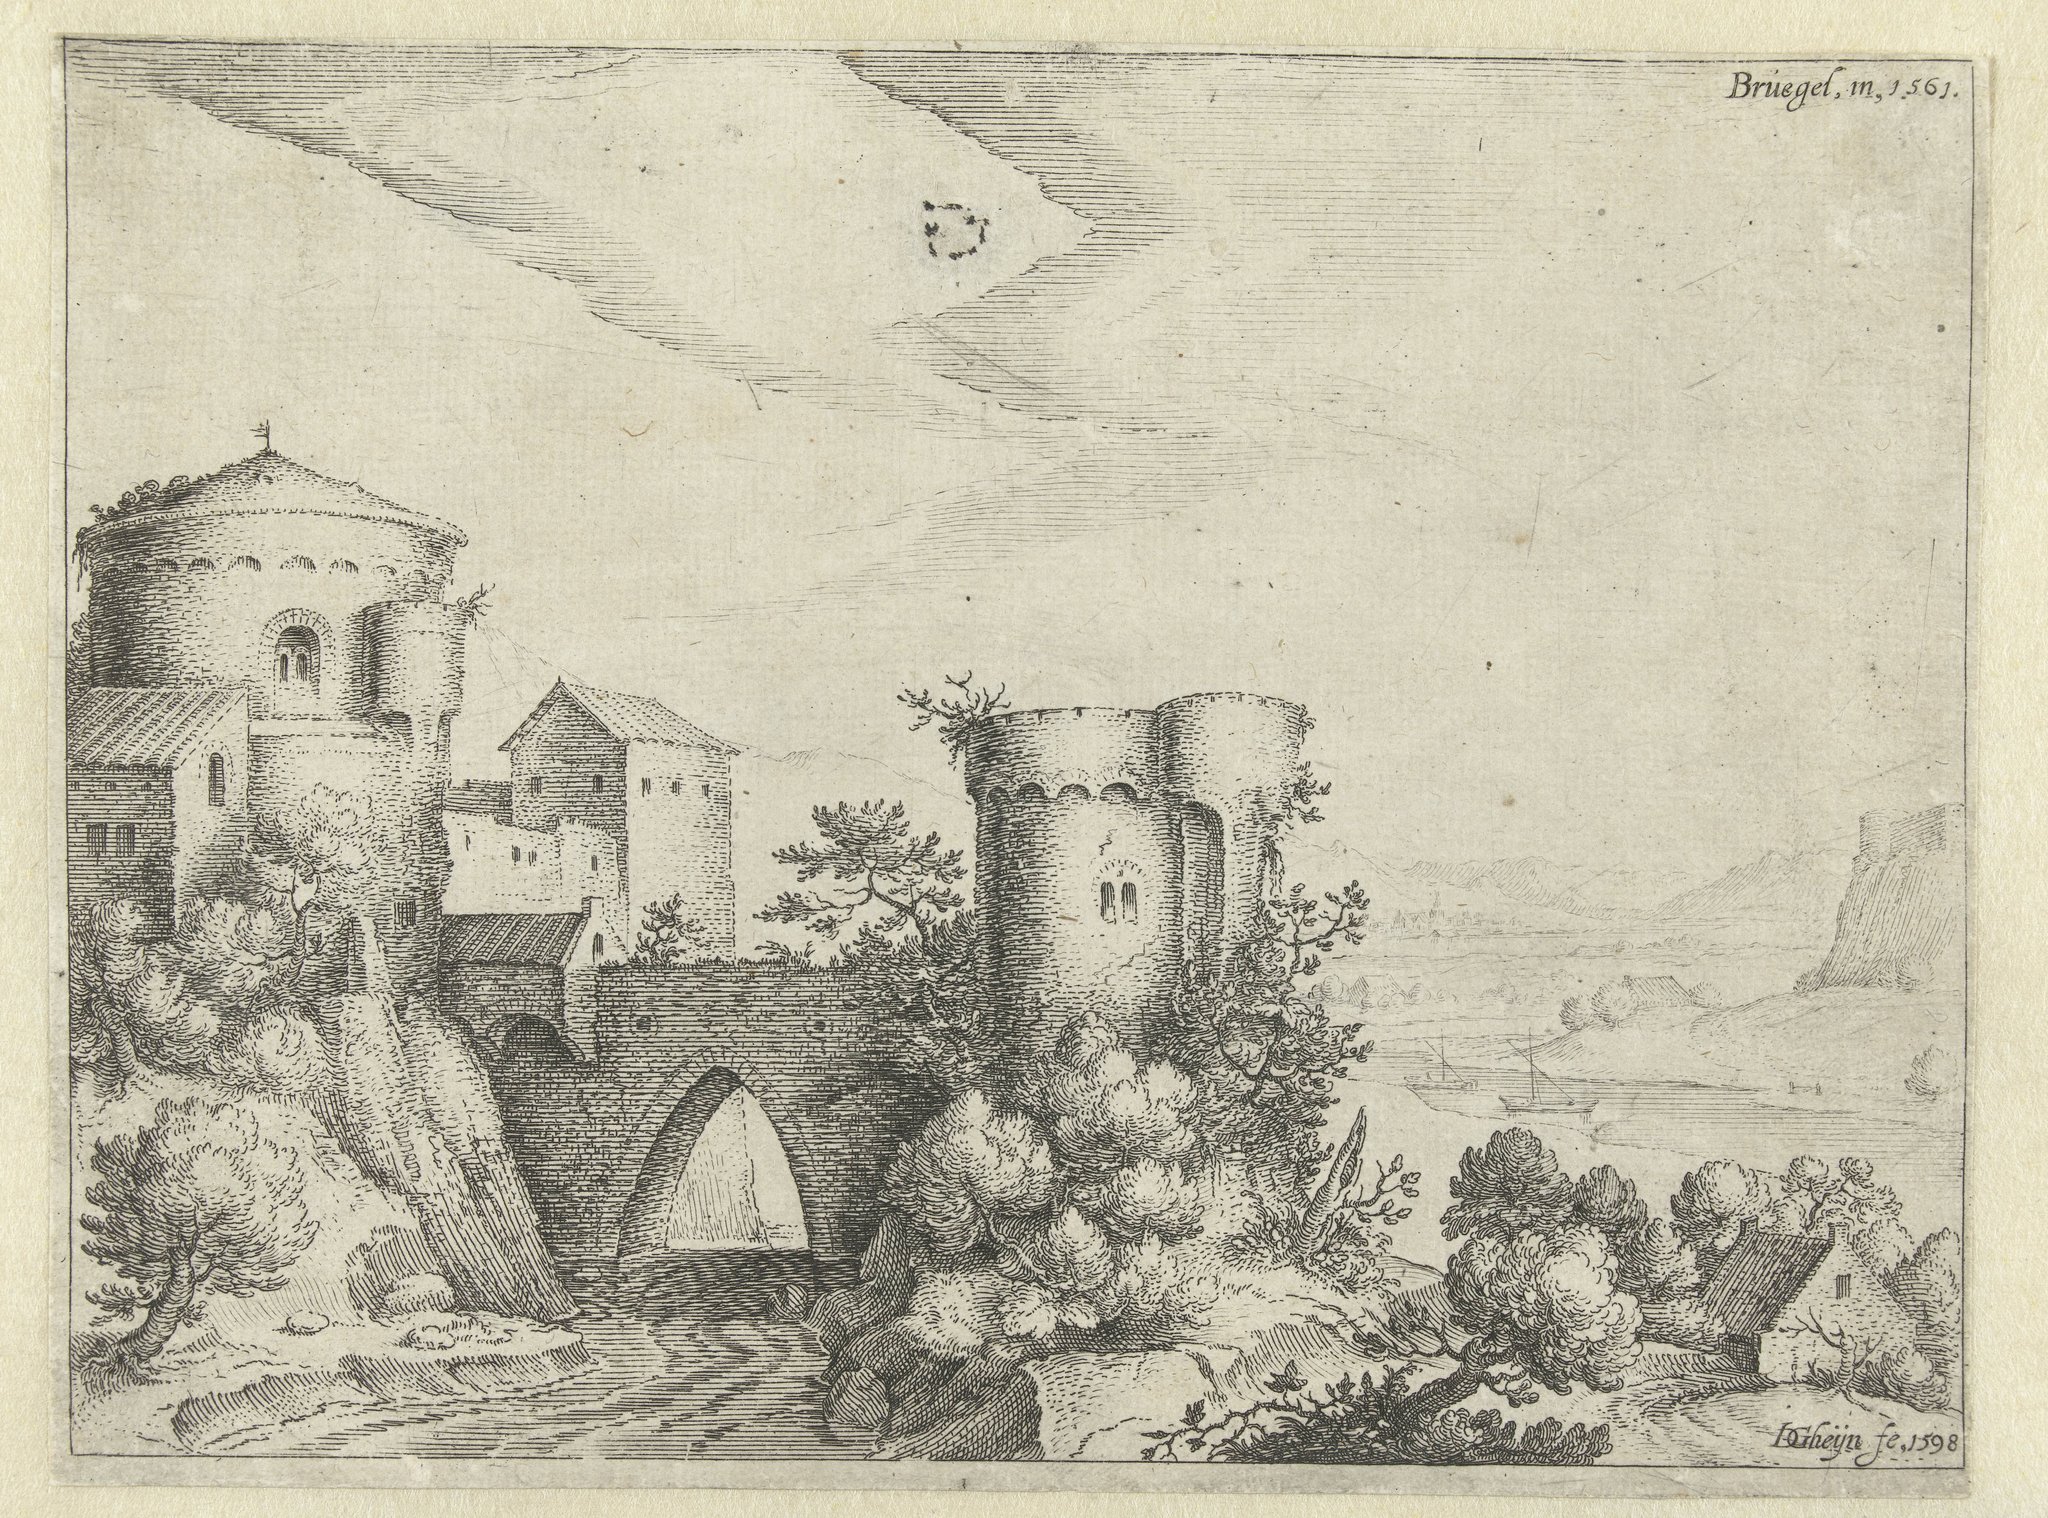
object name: print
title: Rivierlandschap met kasteel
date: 1598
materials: paper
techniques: etching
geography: netherlands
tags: castle, river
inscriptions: collector's mark: Lugt 845, collector's mark: Lugt 2228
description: Kasteel aan rivier in bergachtig landschap.